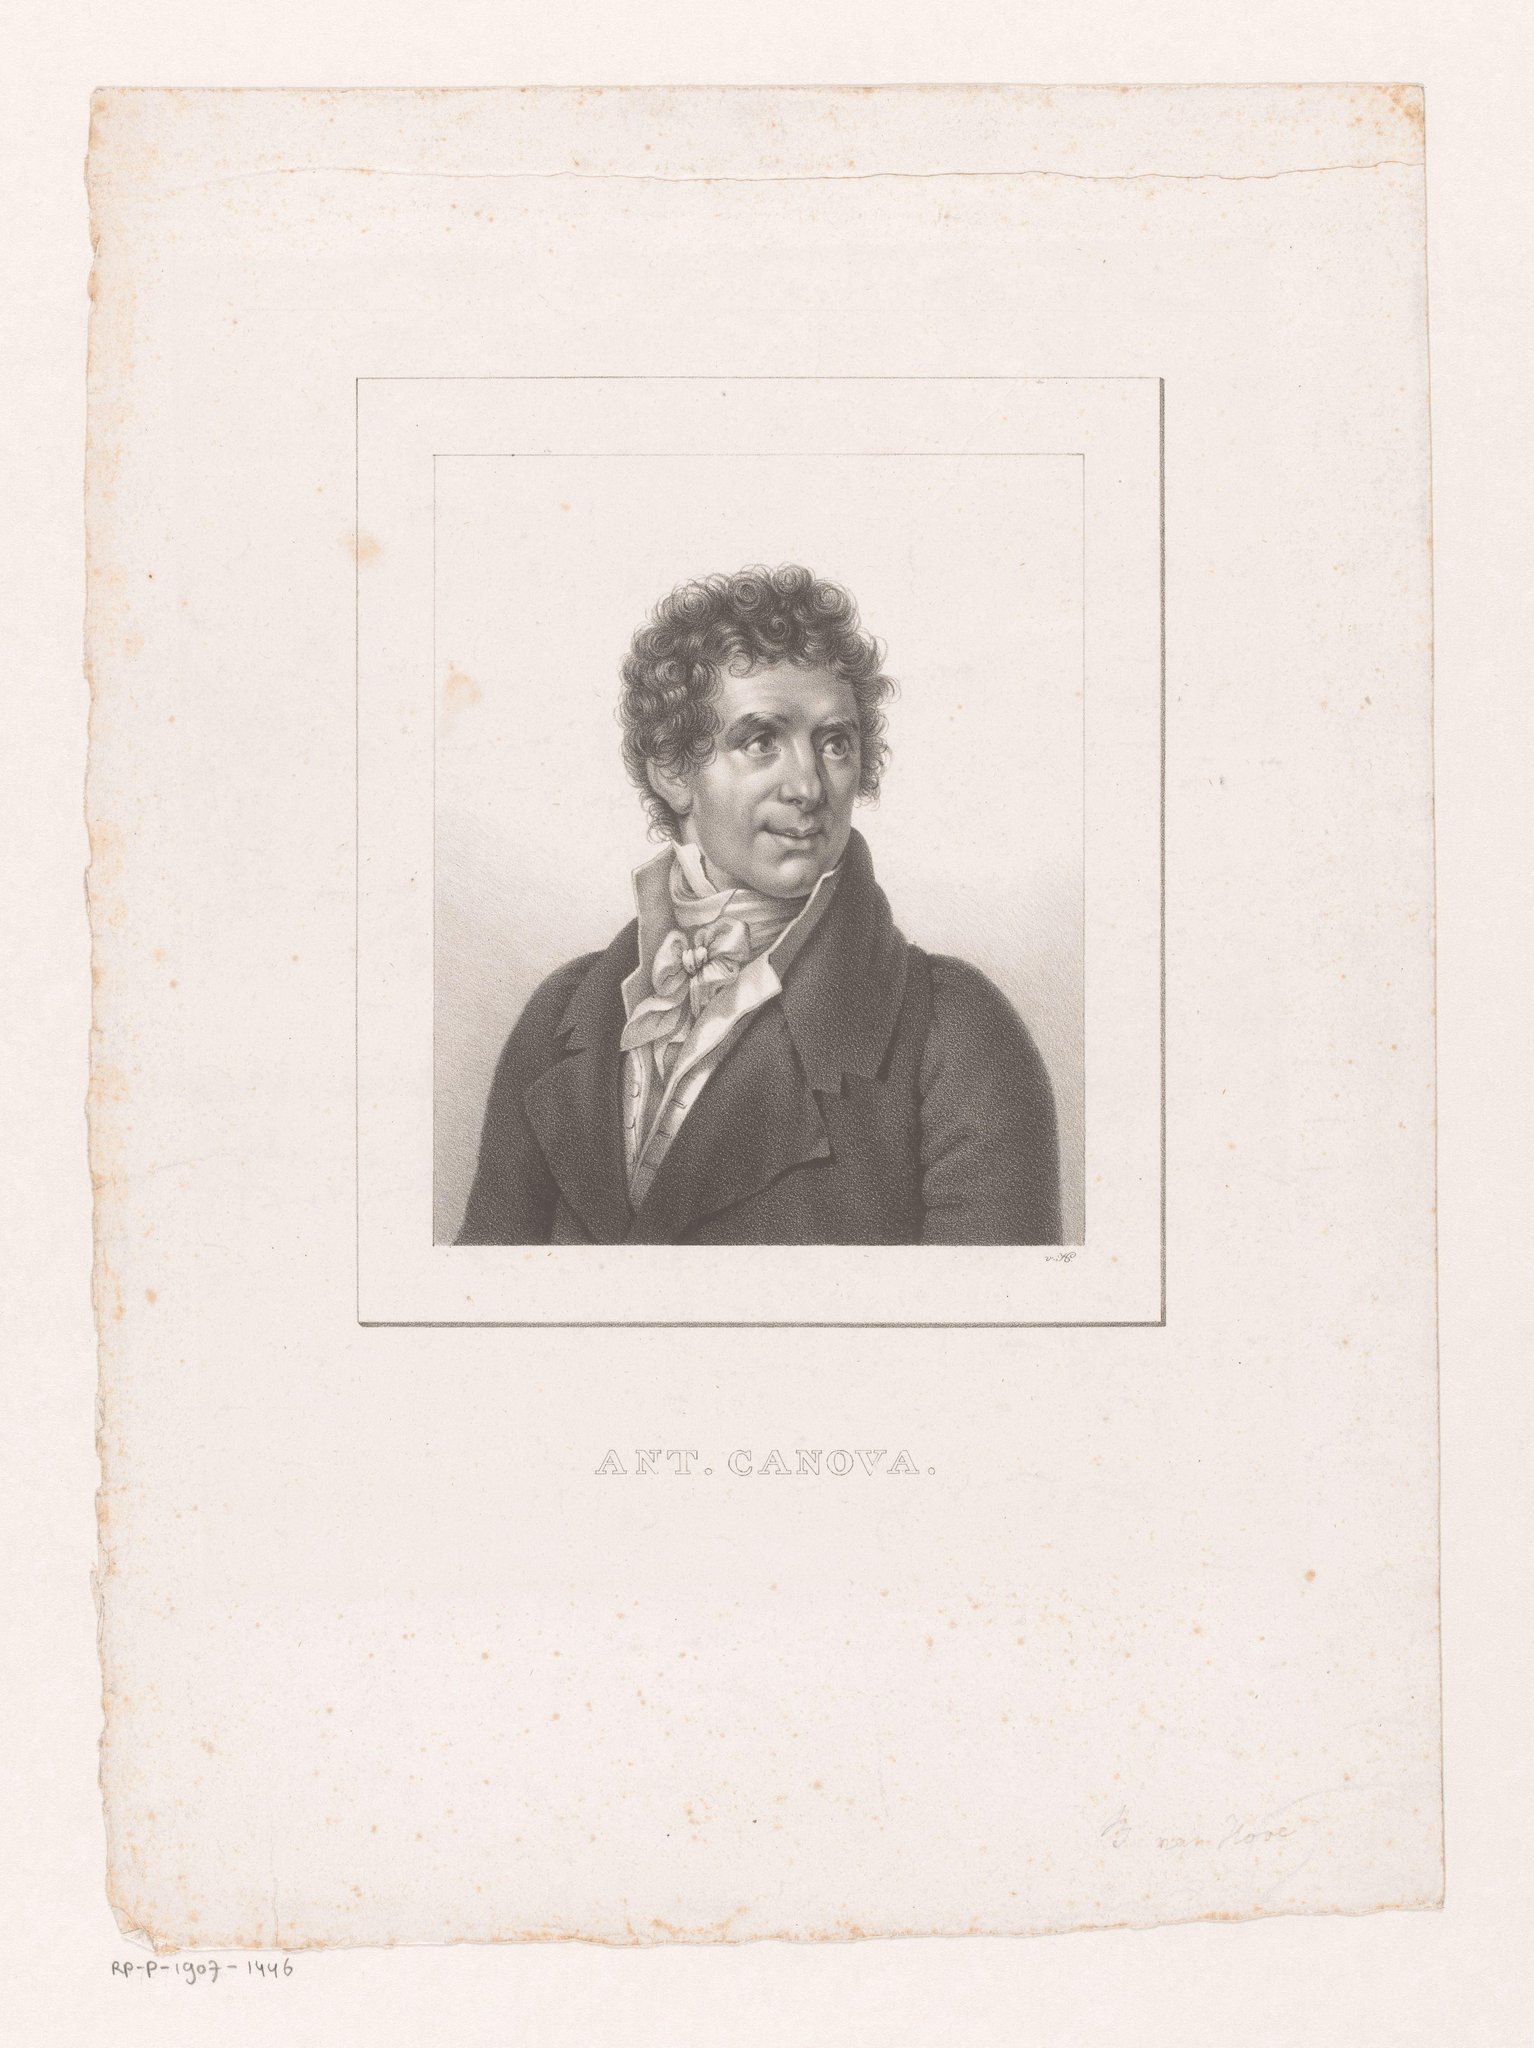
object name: print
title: Portret van Antonio Canova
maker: bartholomeus johannes van hove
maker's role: draughtsman, painter, print maker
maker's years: 1790-1880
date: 1809-1880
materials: paper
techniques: lithograph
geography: netherlands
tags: historical persons (+ (full) bust portrait)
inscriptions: collector's mark: Lugt 2228